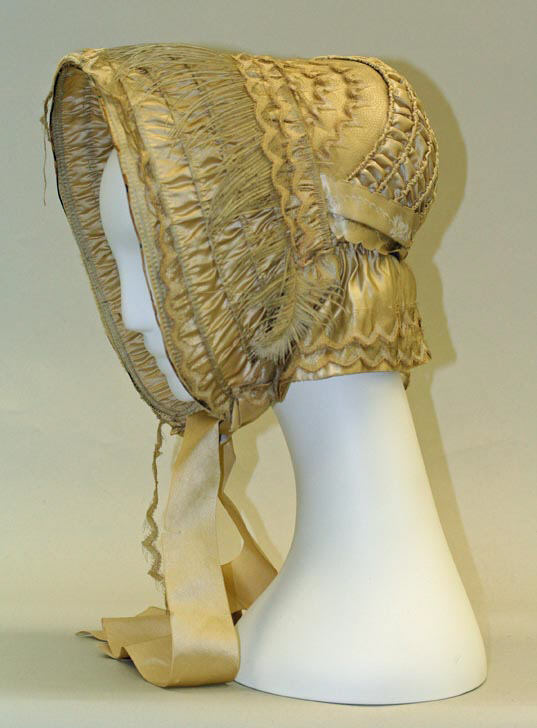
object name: wedding bonnet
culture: french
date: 1849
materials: feather, silk